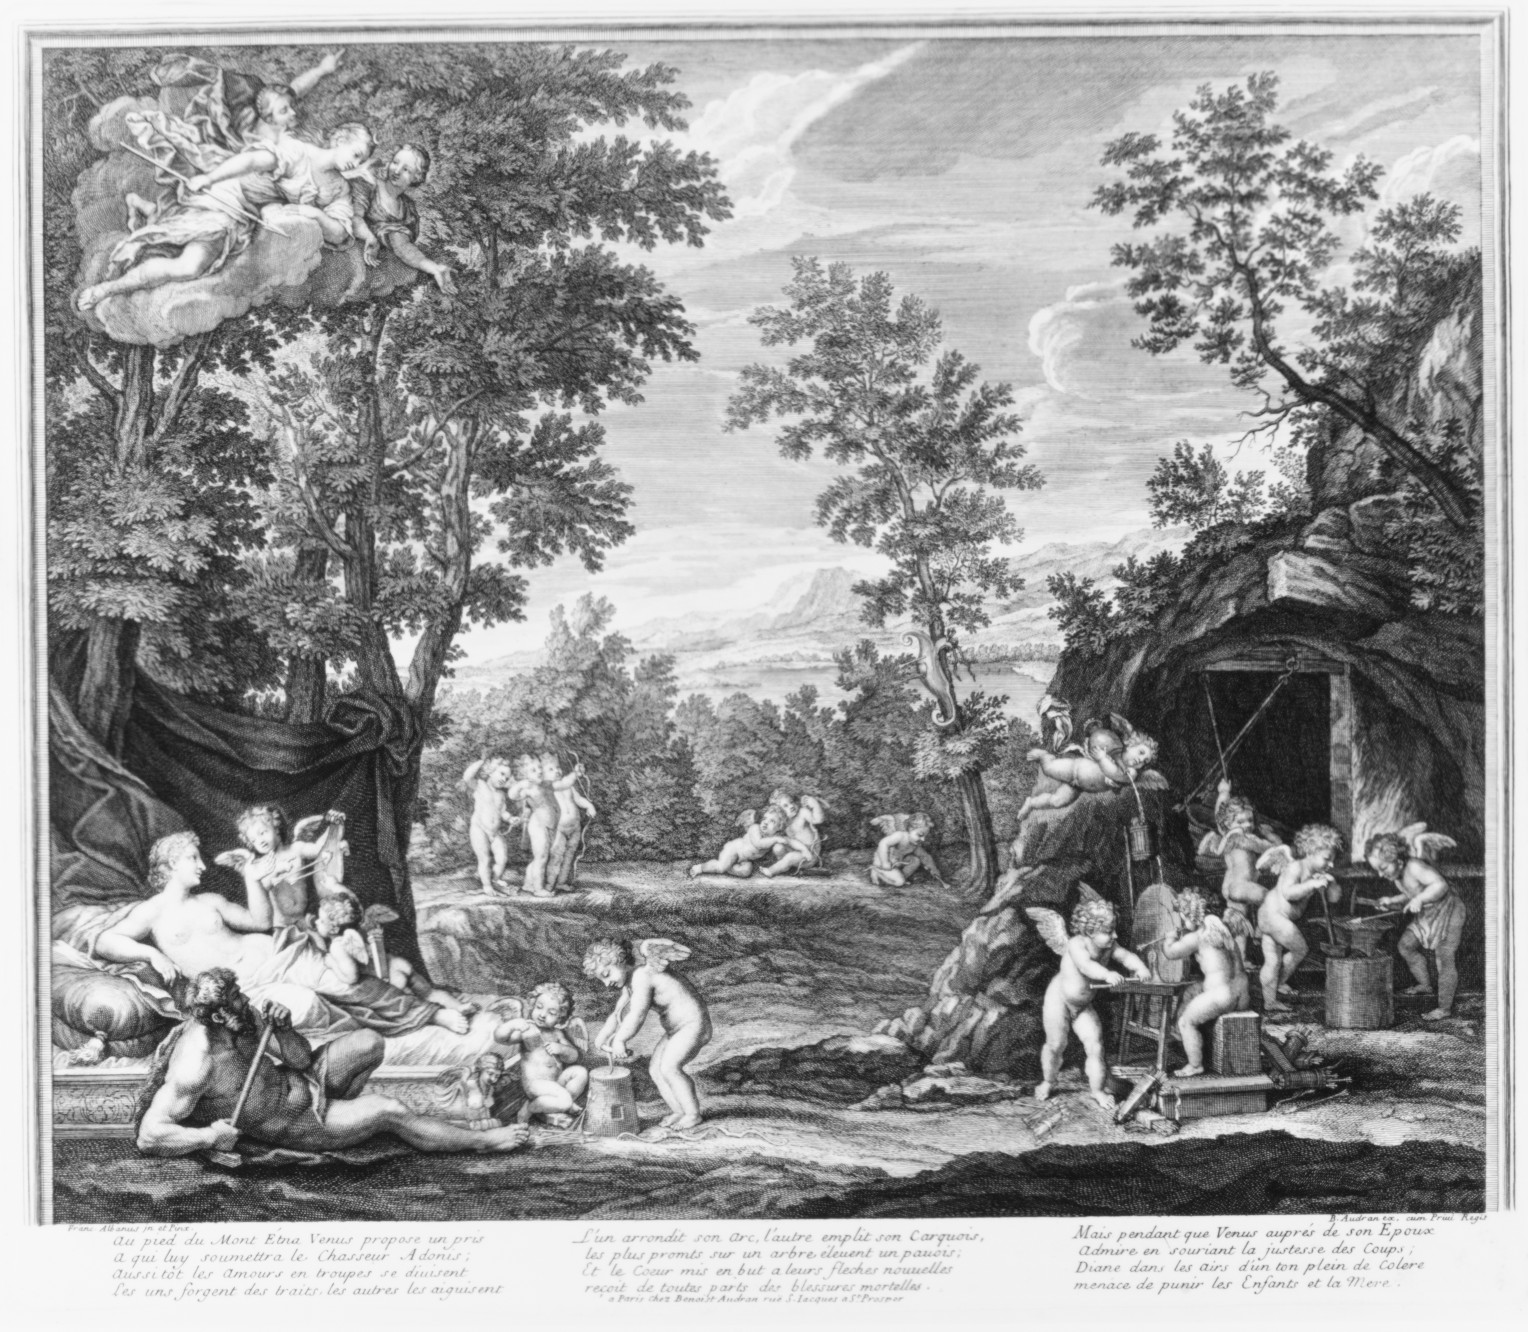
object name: print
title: Leaf from Aedes Walpolianae mounted with two prints: (a): The Loves of Venus and Adonis; (b): The Loves of Venus and Adonis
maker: benoit audran the elder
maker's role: artist and engraver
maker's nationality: french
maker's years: 1661-1721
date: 1741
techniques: engraving, etching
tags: adonis,venus